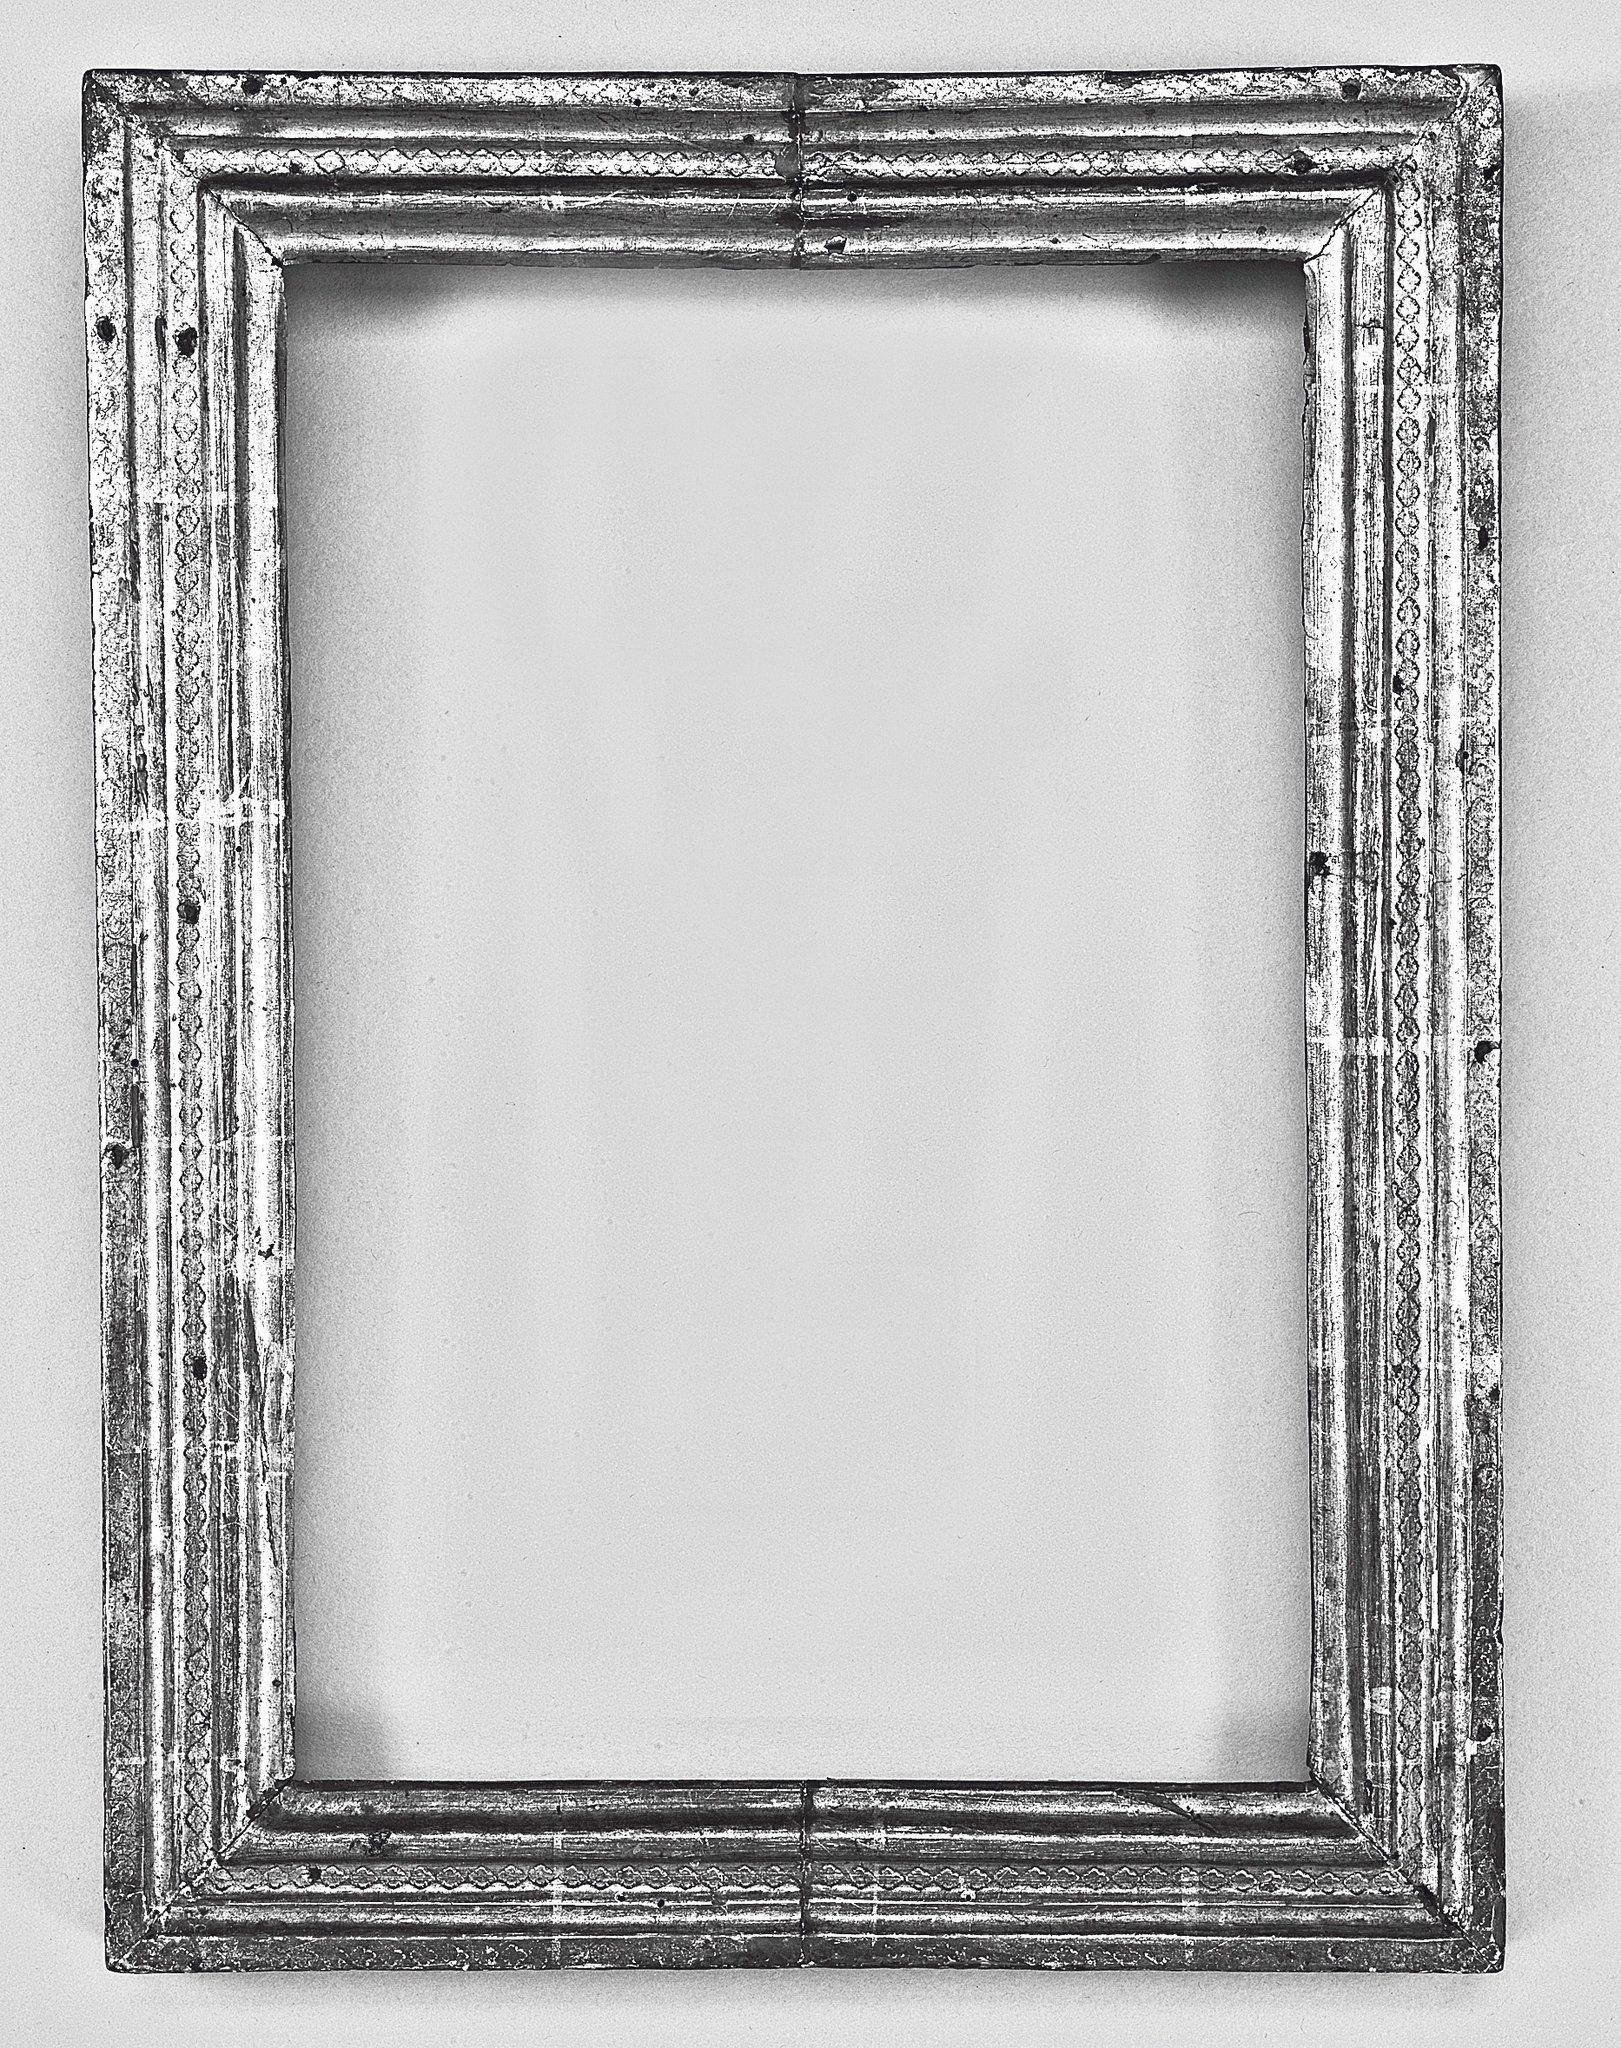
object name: frame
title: Cassetta frame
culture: sienese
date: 1450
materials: gilt, wood